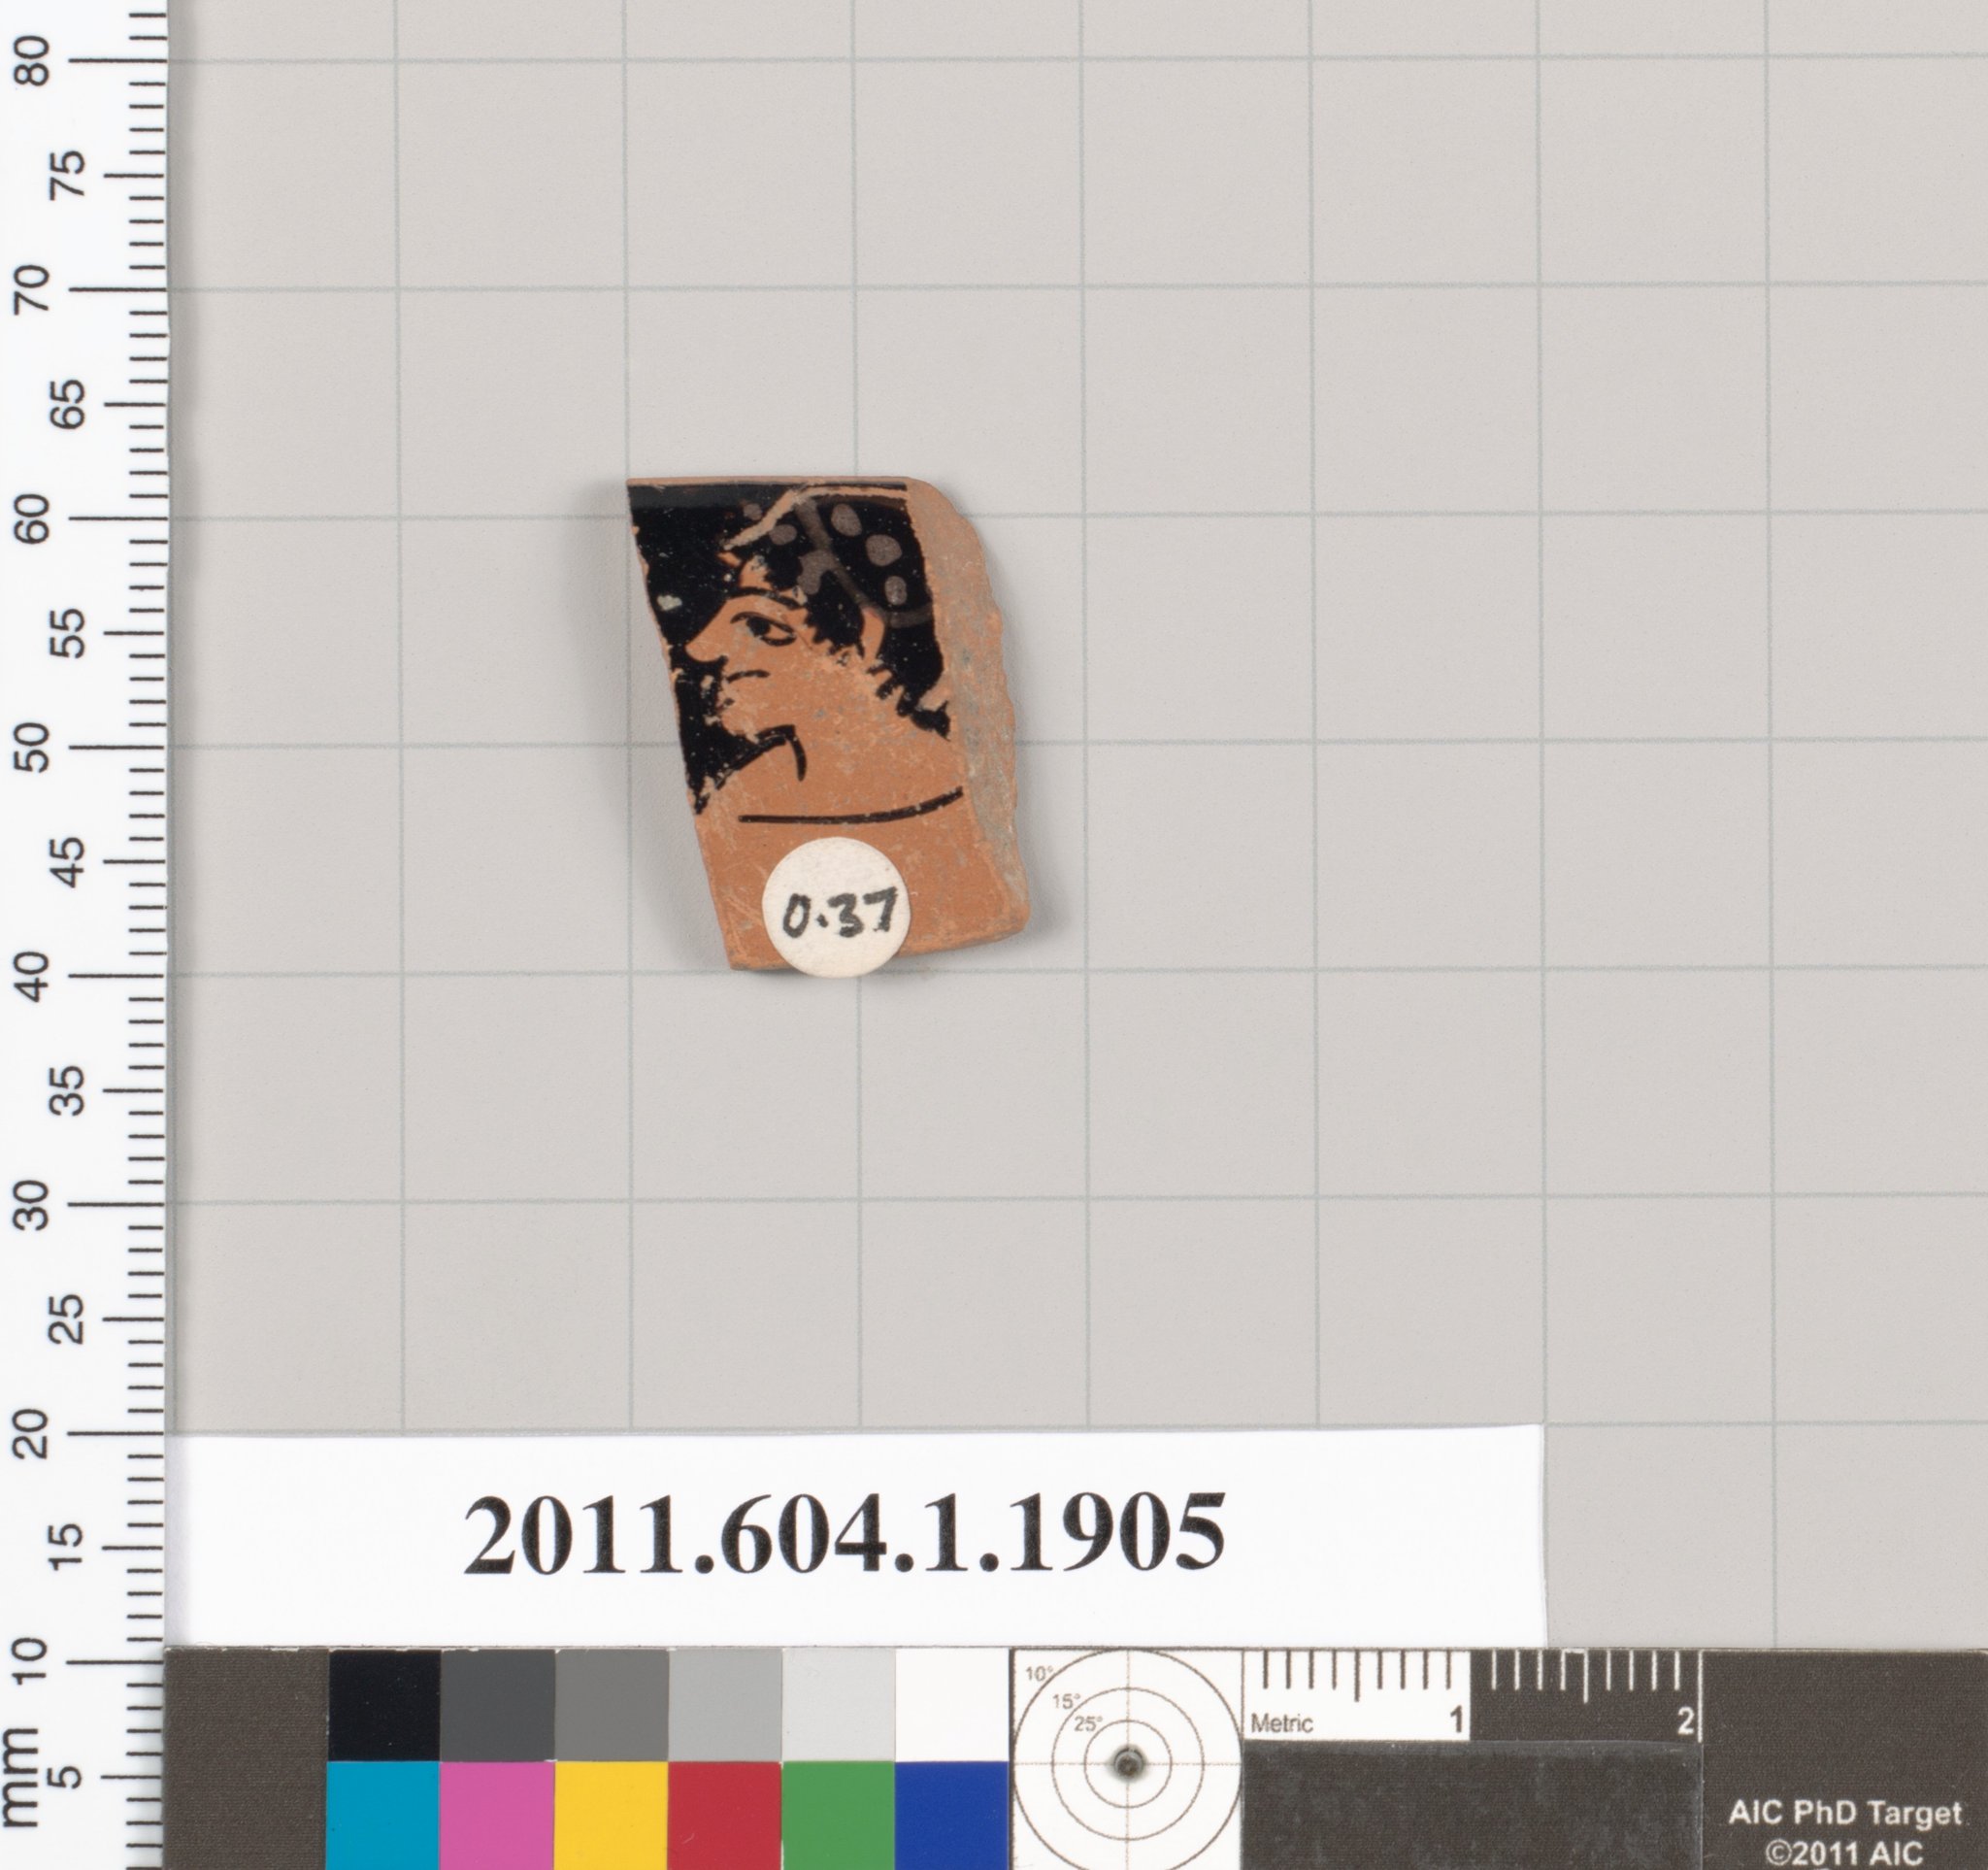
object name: kylix fragment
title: Terracotta rim fragment of a kylix (drinking cup)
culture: greek, attic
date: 534-501 BCE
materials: terracotta